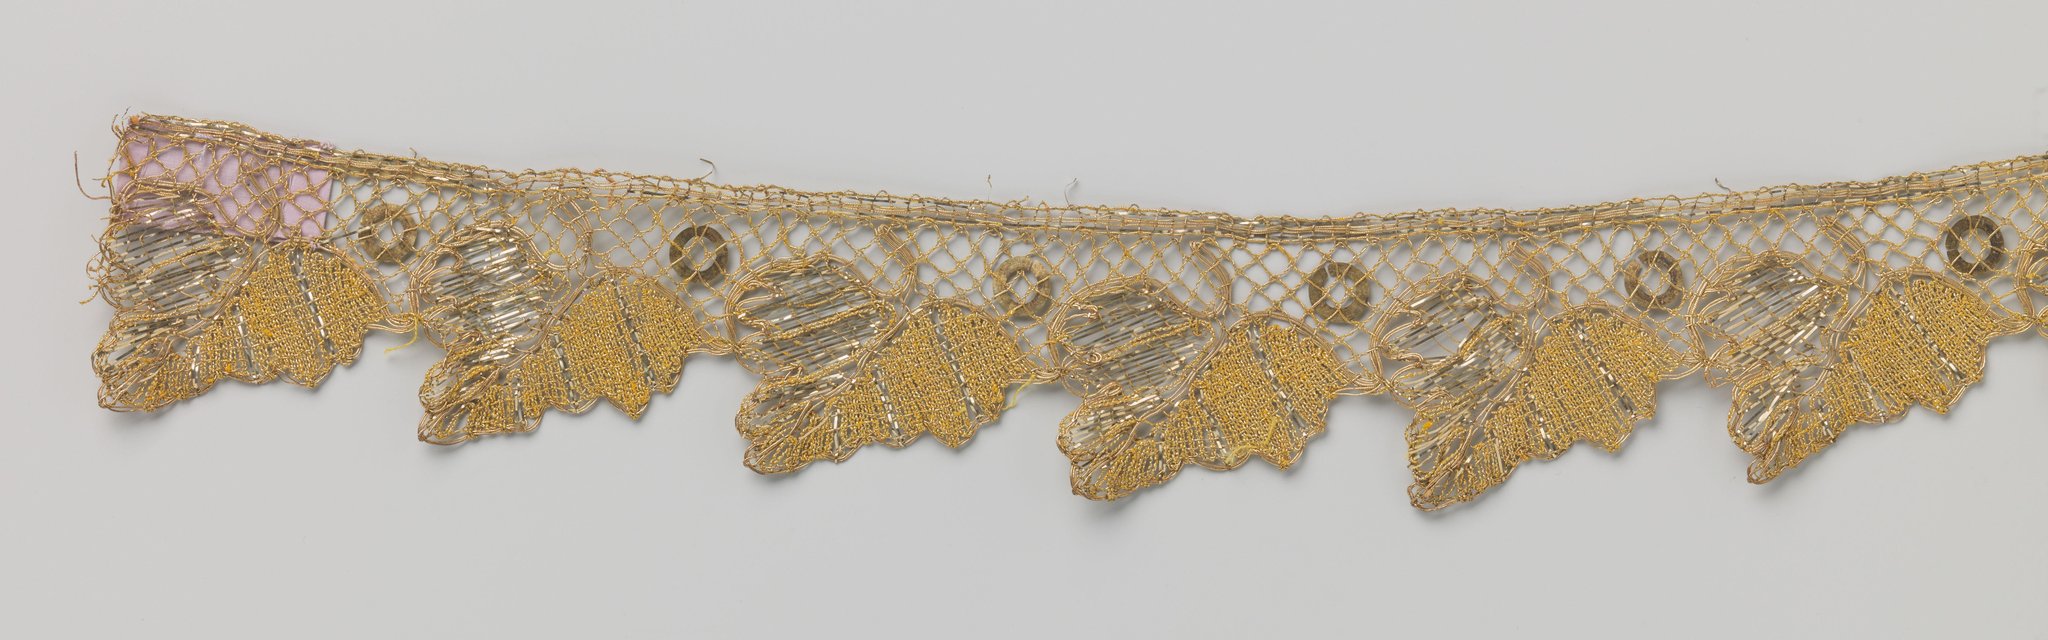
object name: strip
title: Strook goudkant met eenzijdig gerichte klimopbladeren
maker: Anonymous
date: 1800-1899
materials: gold thread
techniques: lace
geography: spain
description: Strook kloskant, goudkant. Het patroon bestaat uit een aaneenschakeling van eenzijdig gerichte bladeren, die de vorm hebben van klimopbladeren of wijnbladeren. De bladeren vormen de schulpen langs de onderzijde van de strook. Boven de bladeren is een maasgrond gemaakt, een vetergatslagtralie-grond. Er is gewerkt met lamelgouddraad, gladde filégaren en geribbelde filégaren, in verschillende diktes. De ene helft van elk blad is voornamelijk gevuld met lamelgouddraad, met enkele accentlijnen van geribbelde filégaren. Bij de andere helft is dit andersom. De steel van het blad, de contourlijnen en de nerf in het midden zijn gemaakt met dikkere filégaren. In de grond is tussen elk blad één platte ringvormige paillette tussen de draden van de tralies door gestoken.